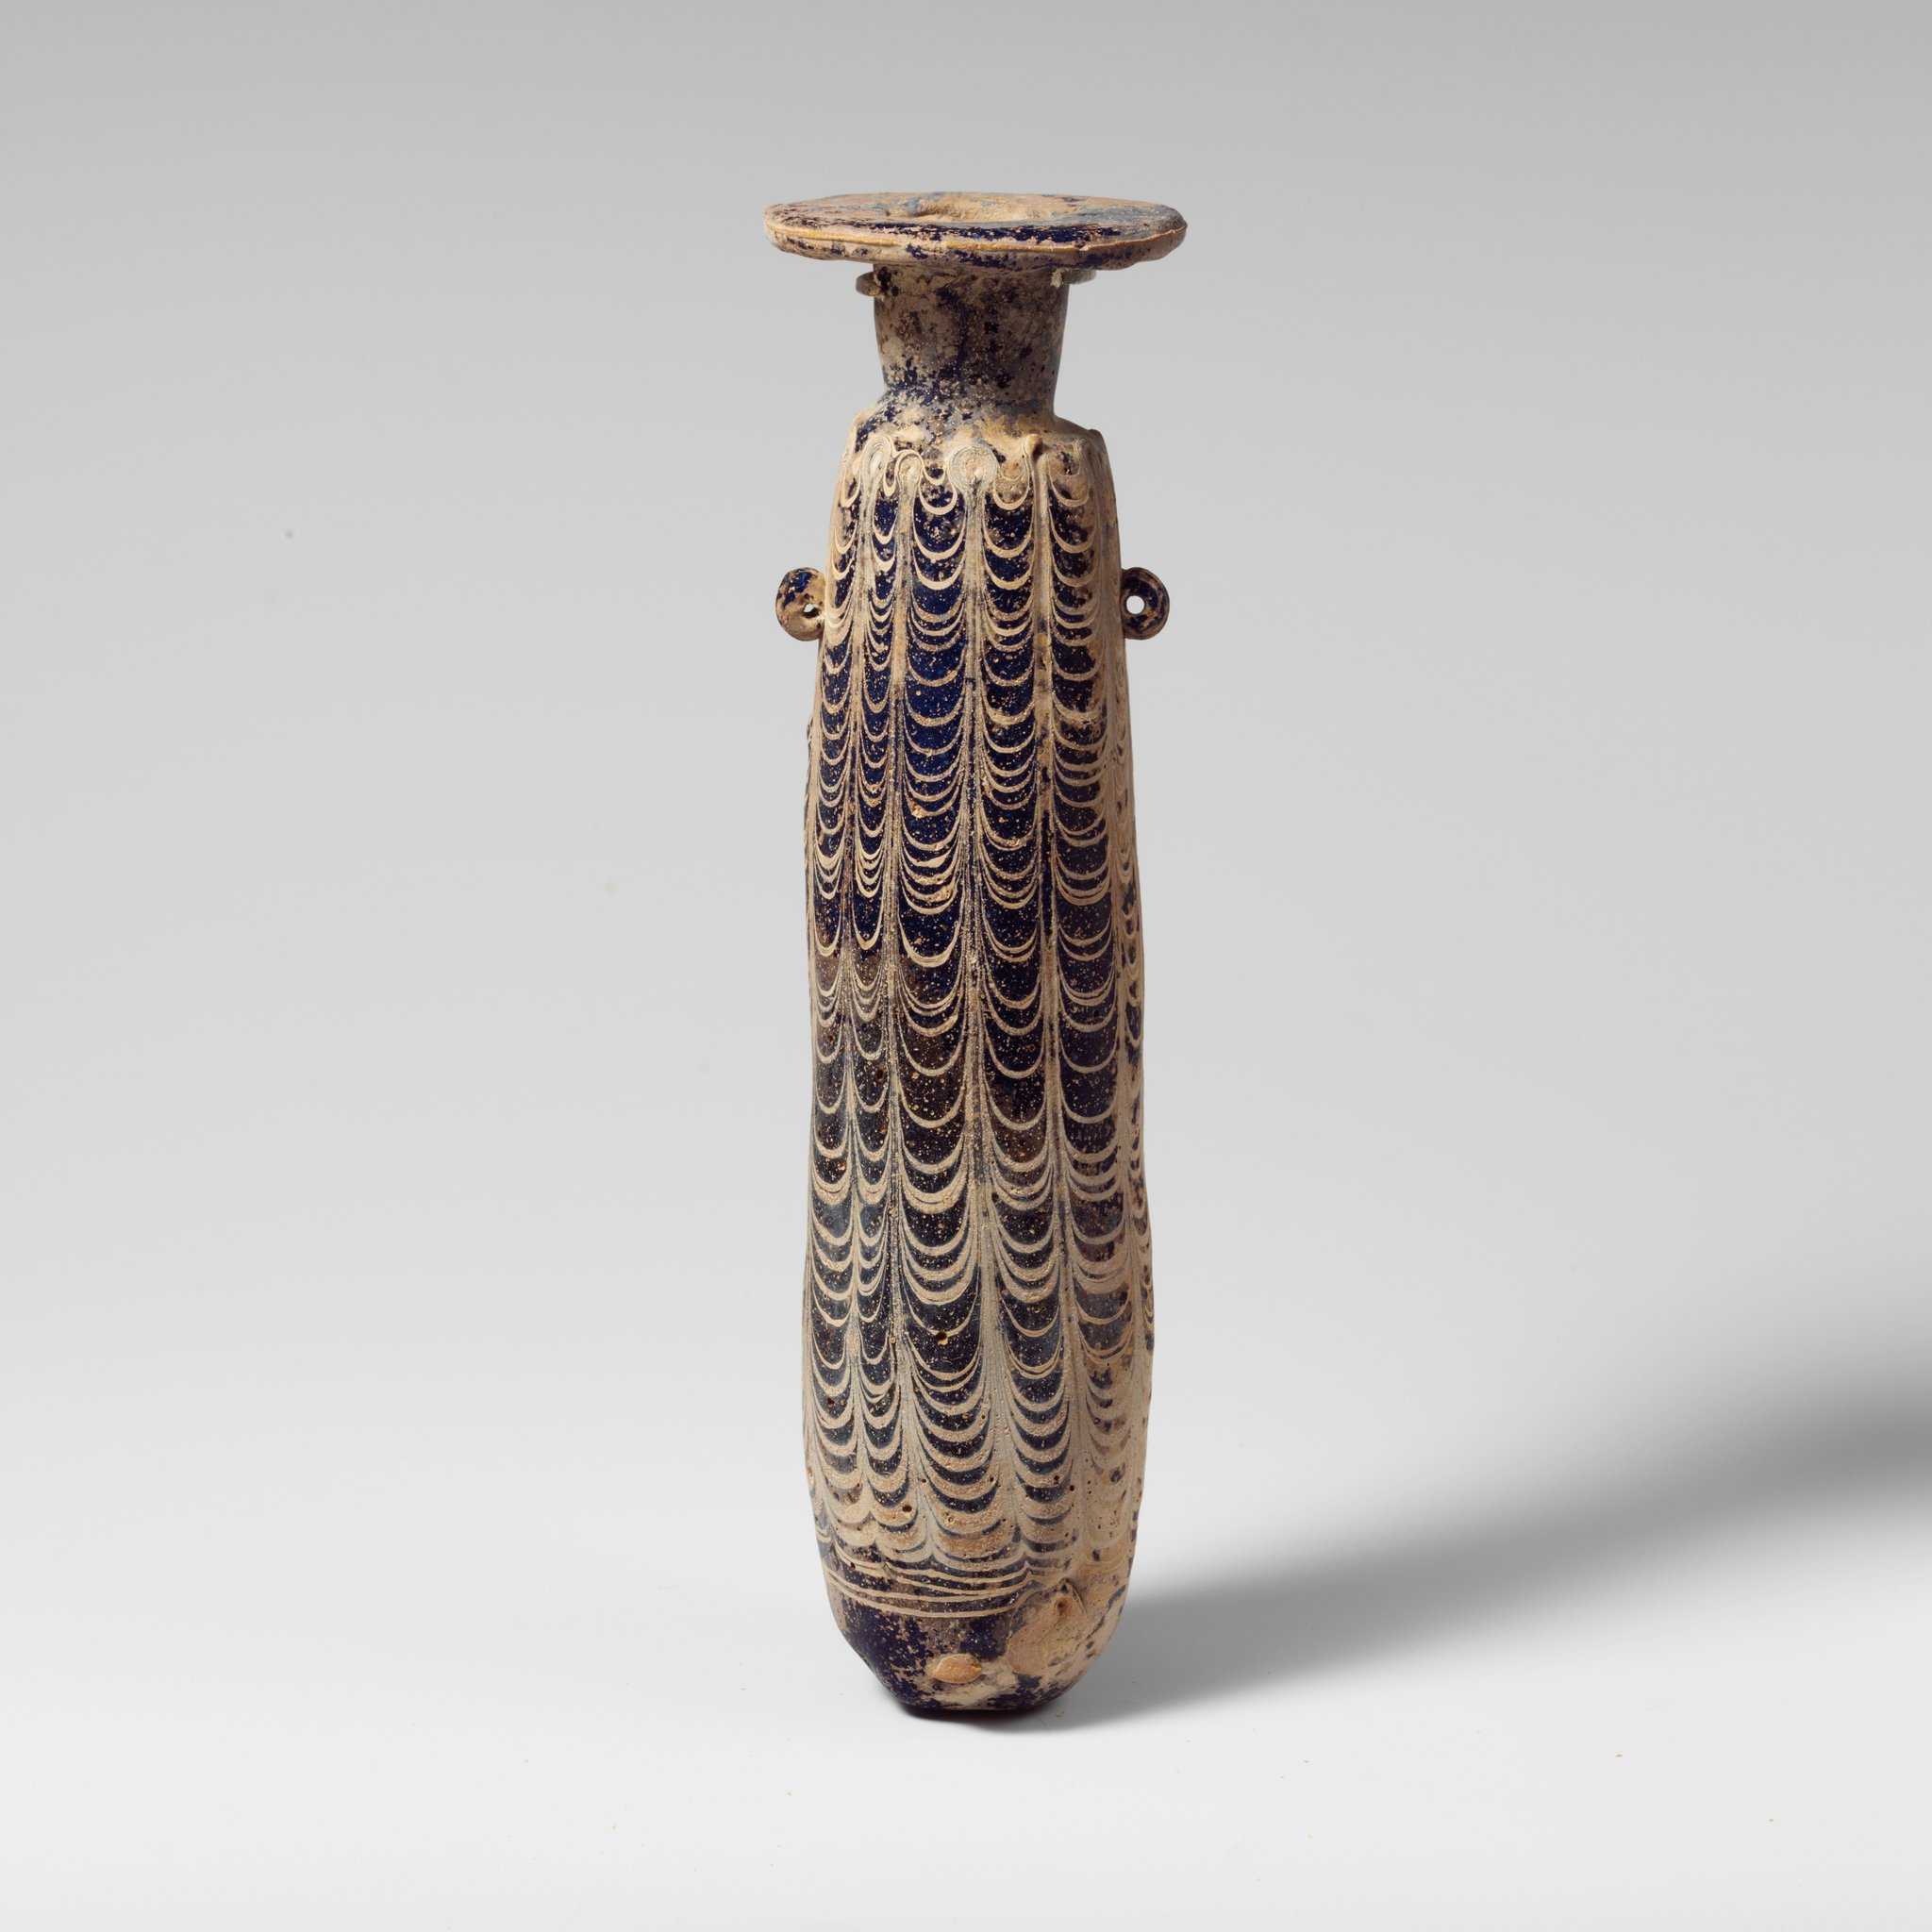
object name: alabastron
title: Glass alabastron (perfume bottle)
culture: eastern mediterranean or italian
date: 367-268 BCE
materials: glass